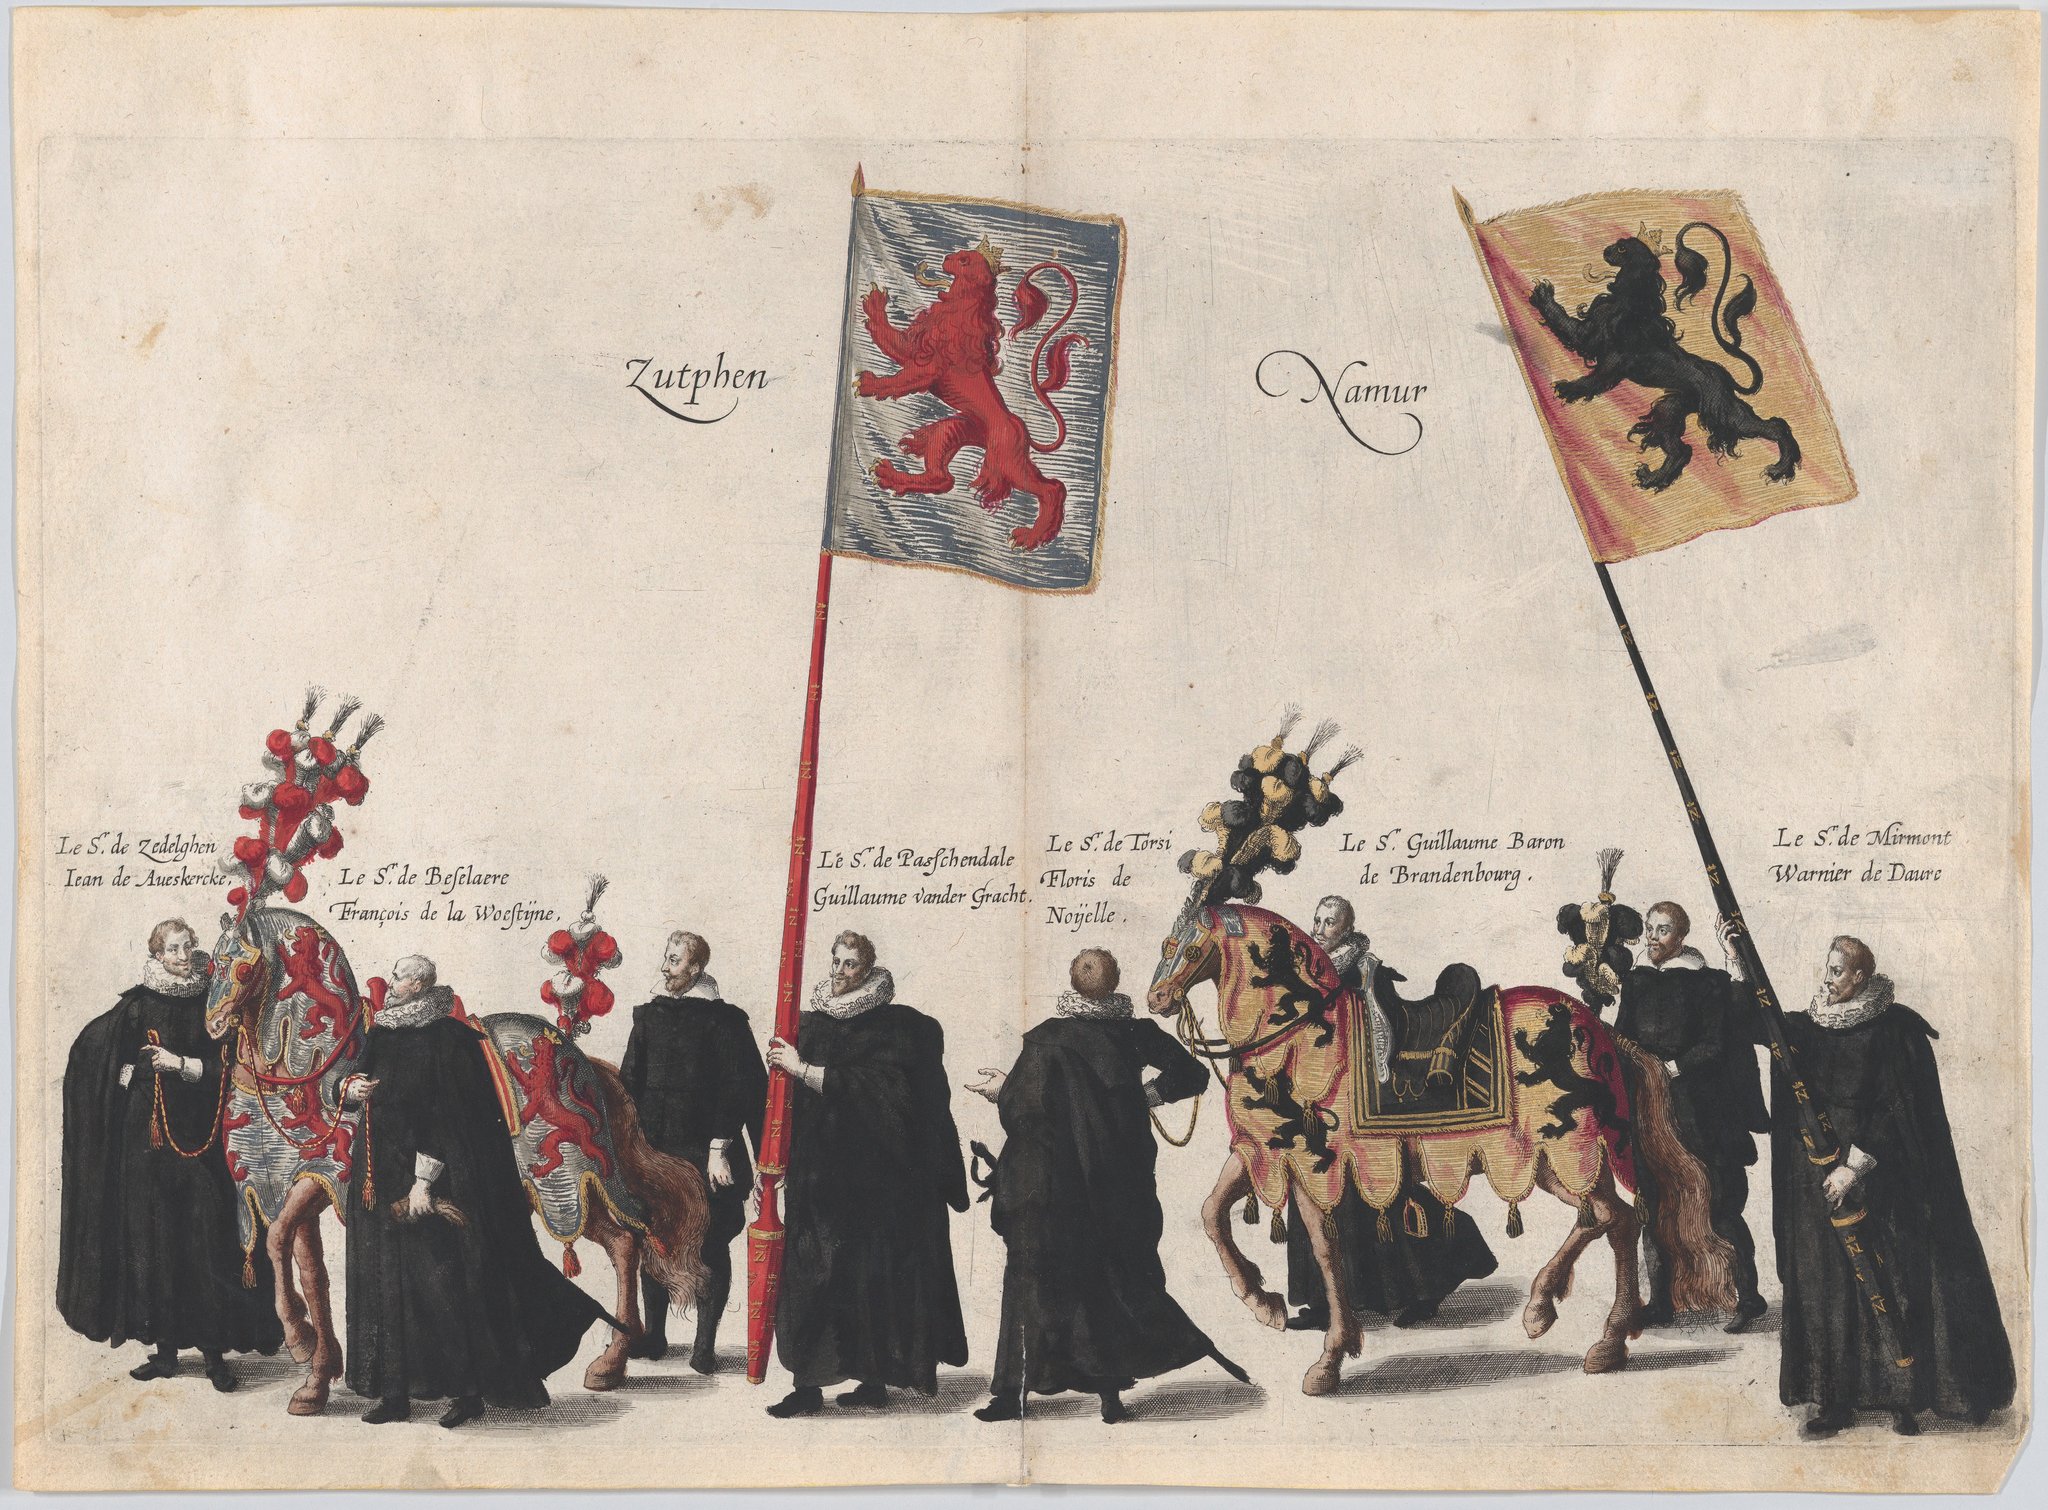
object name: print, fete, ornament architecture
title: Plate 36: Men with heraldic flags and horses from Zutphen and Namur marching in the funeral procession of Archduke Albert of Austria; from 'Pompa Funebris ... Alberti Pii'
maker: cornelis galle (i)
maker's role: artist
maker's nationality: netherlandish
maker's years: 1576-1650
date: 1623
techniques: etching, hand coloring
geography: brussels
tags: men,horses,flags